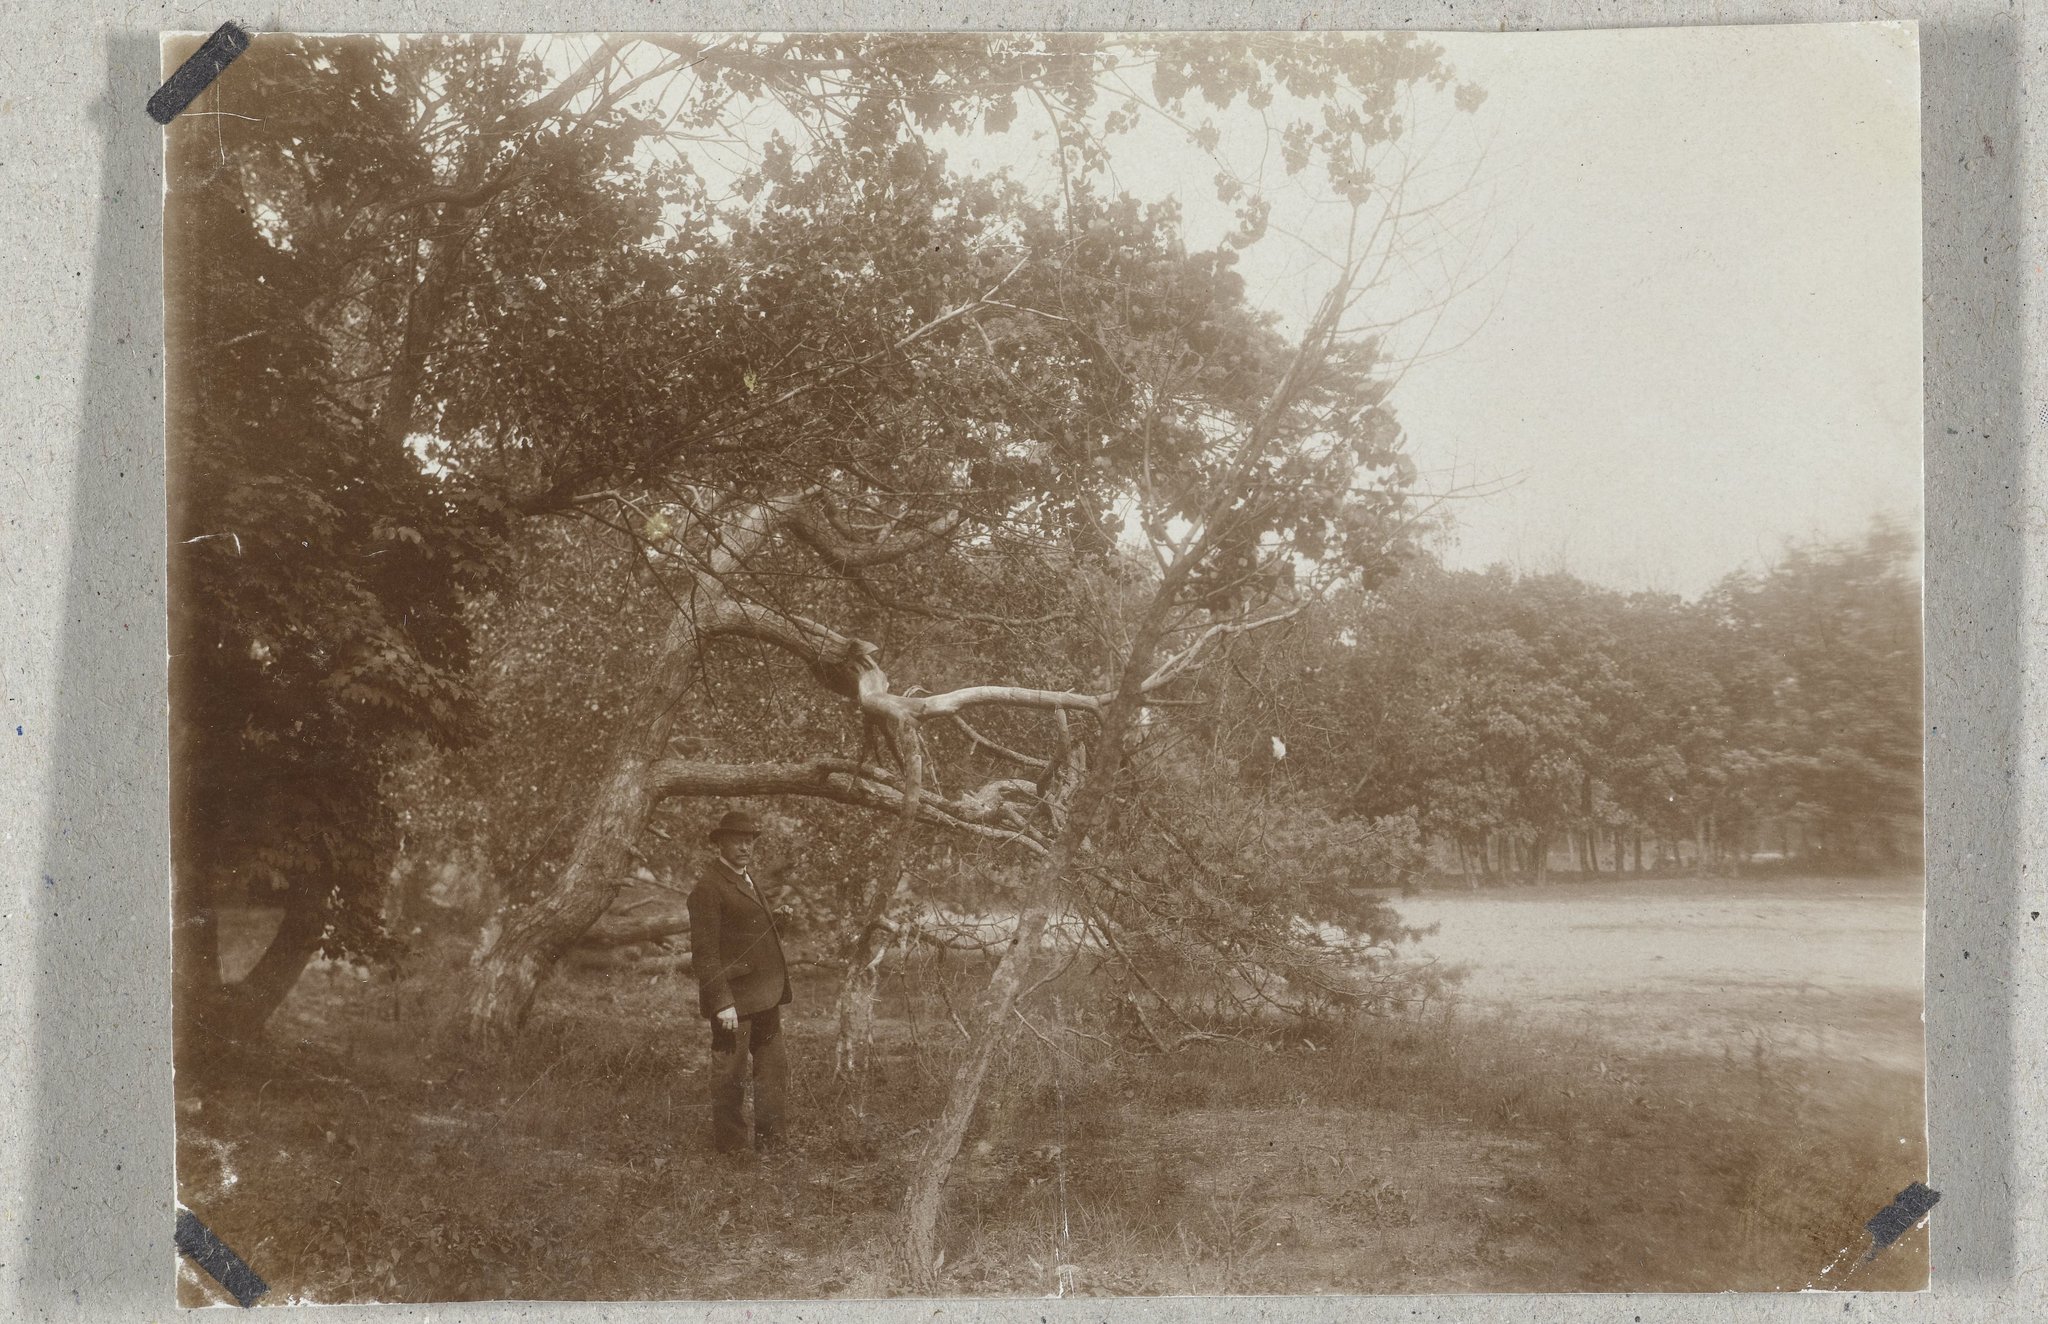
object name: photograph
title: Gezicht in het Meijendel bij Wassenaar en Den Haag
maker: Anonymous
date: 1923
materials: photographic support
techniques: collodion silver print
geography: netherlands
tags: landscapes